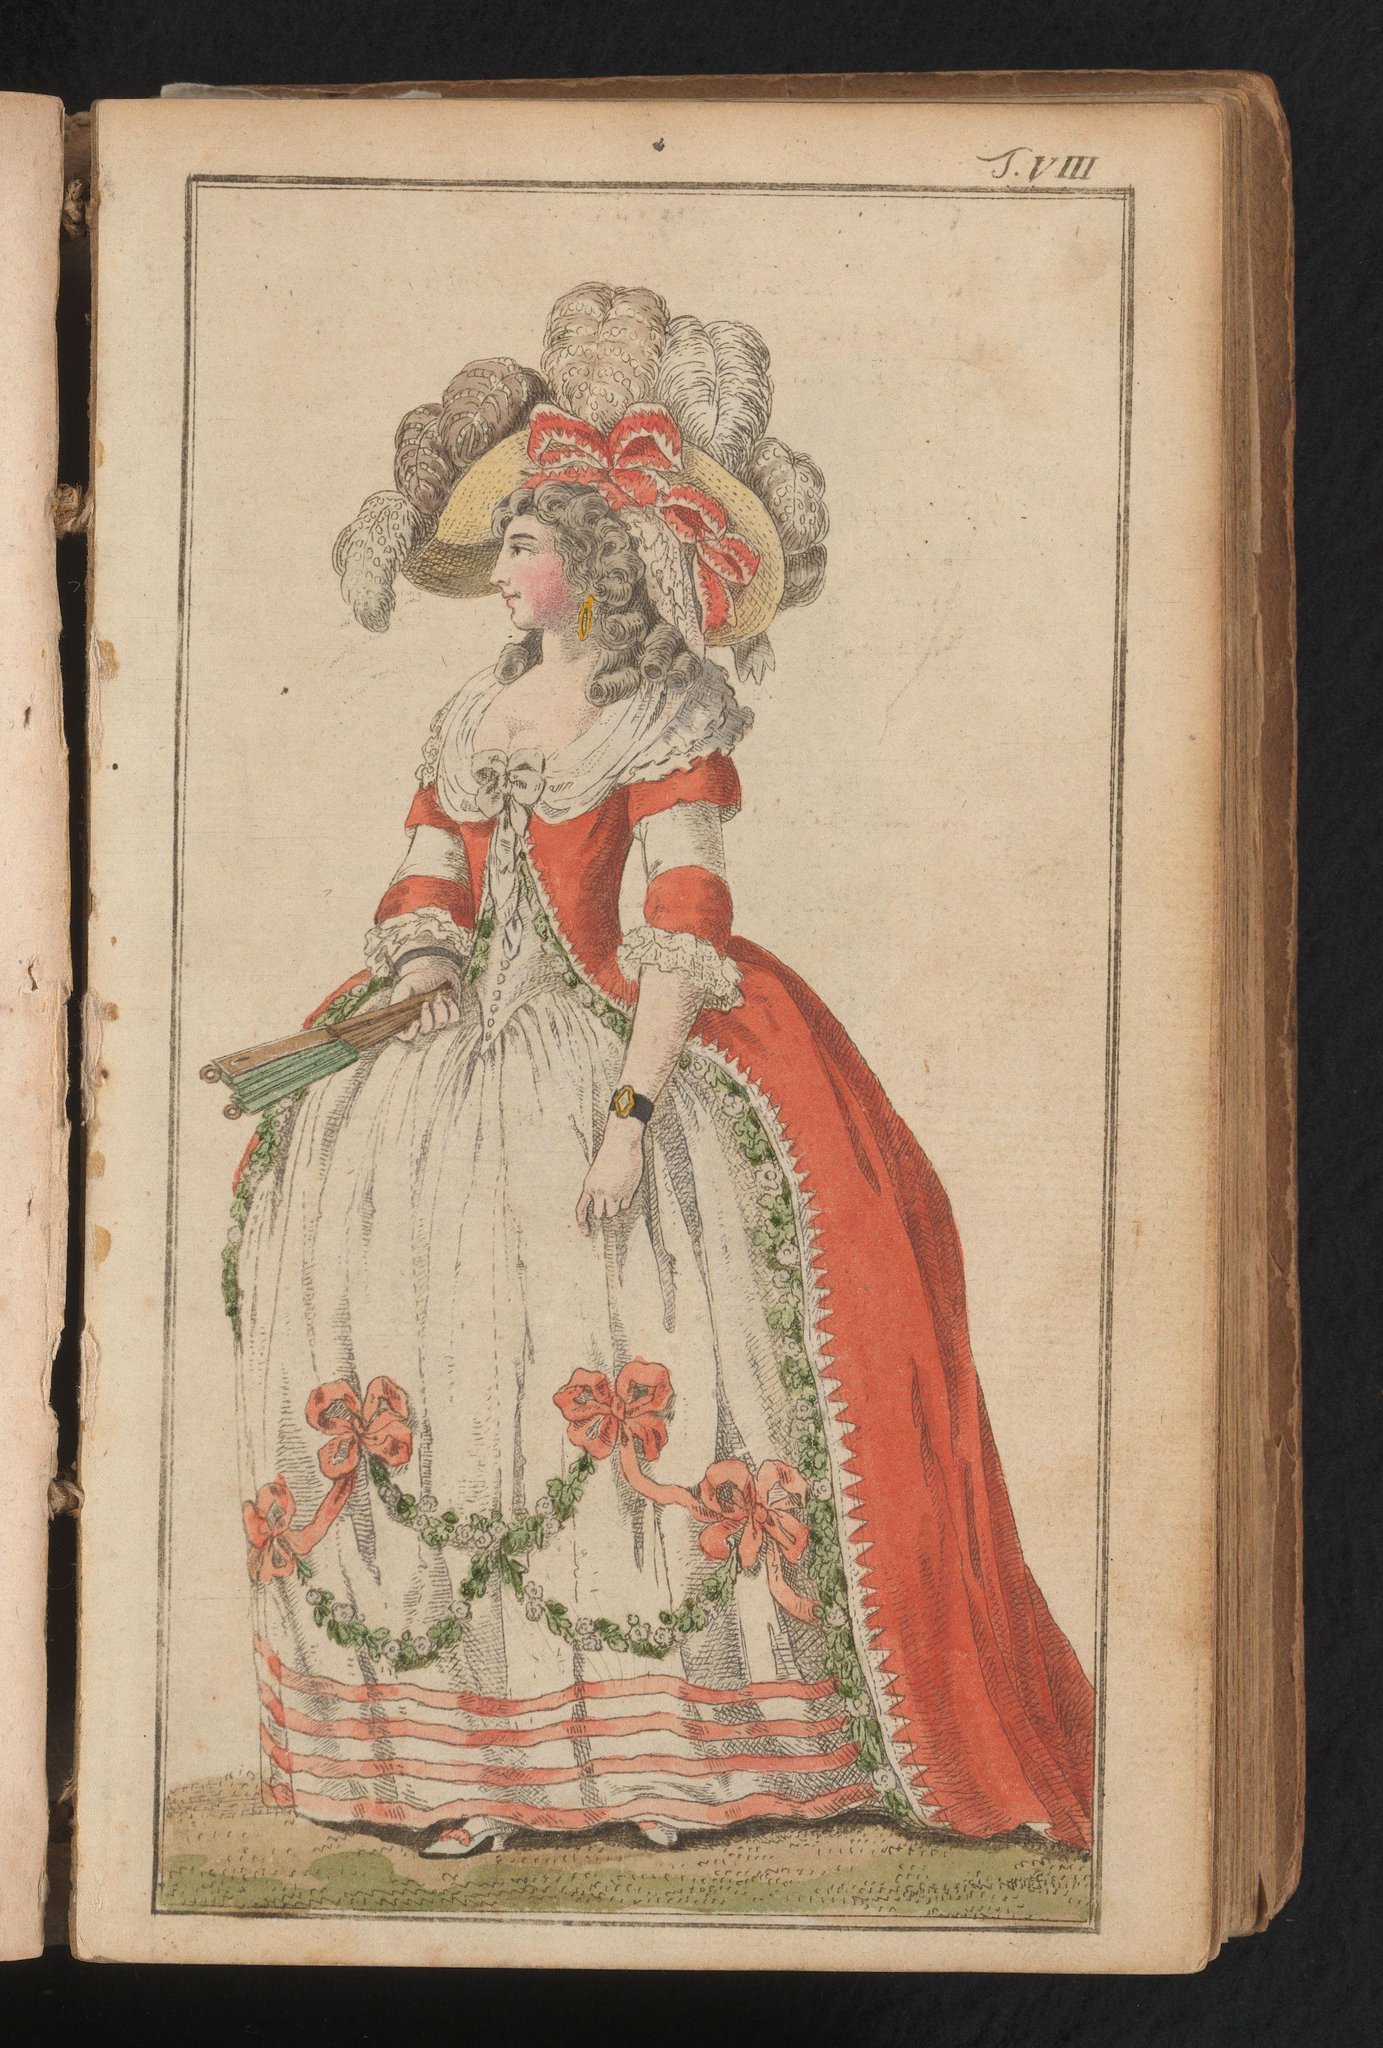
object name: magazine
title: Journal der Moden 1786. T. VIII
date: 1786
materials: paper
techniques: etching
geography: gotha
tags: fashion plates